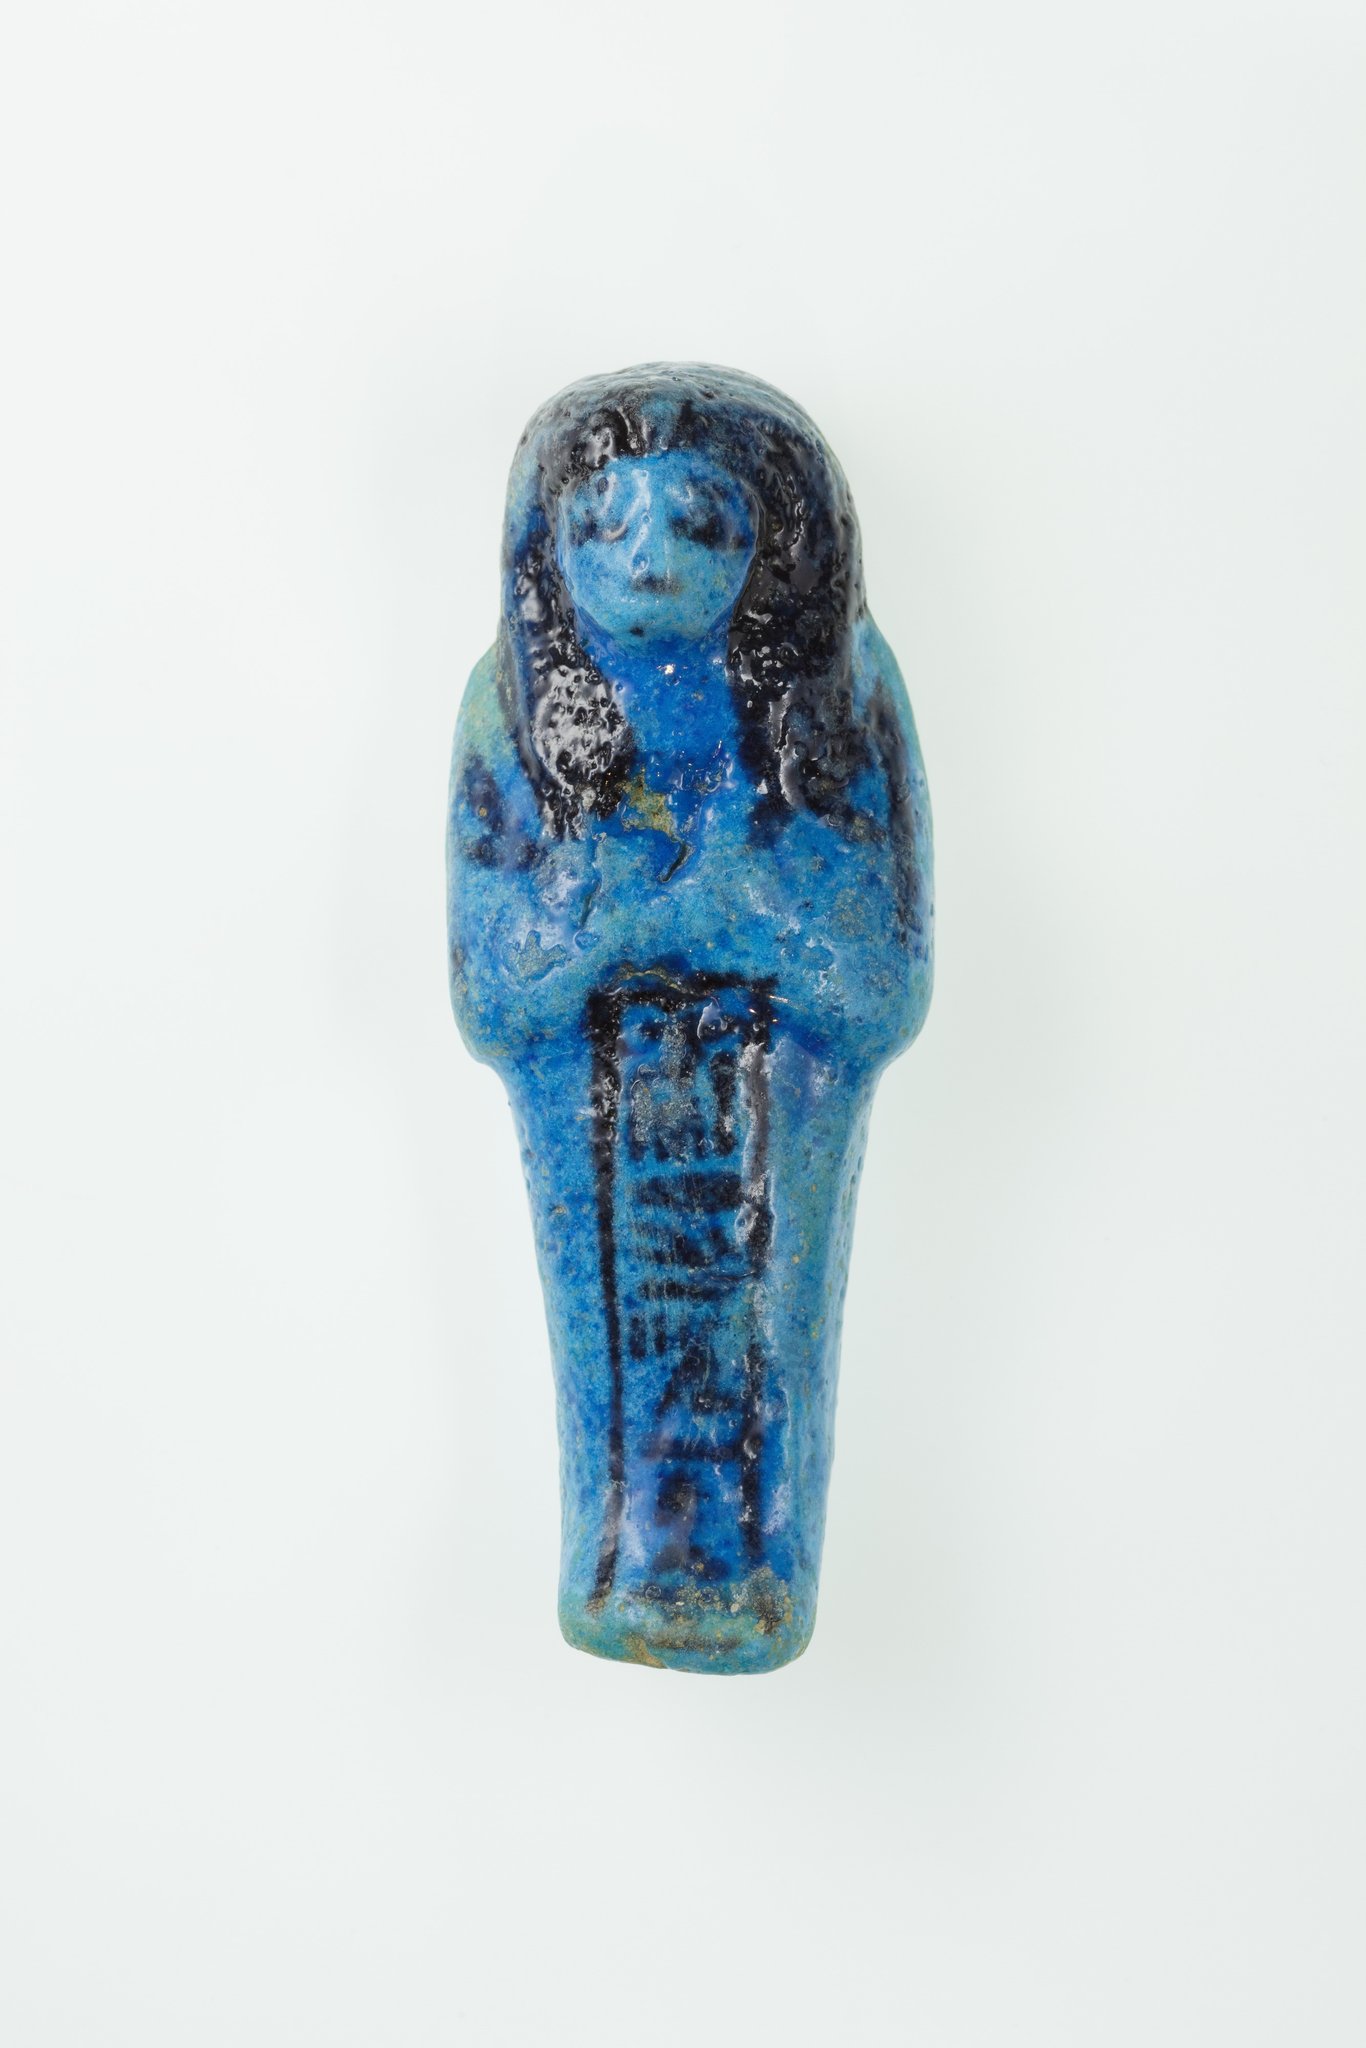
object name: shabti, worker, nauny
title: Worker Shabti of Nauny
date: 1050 BCE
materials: faience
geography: egypt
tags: hieroglyphs